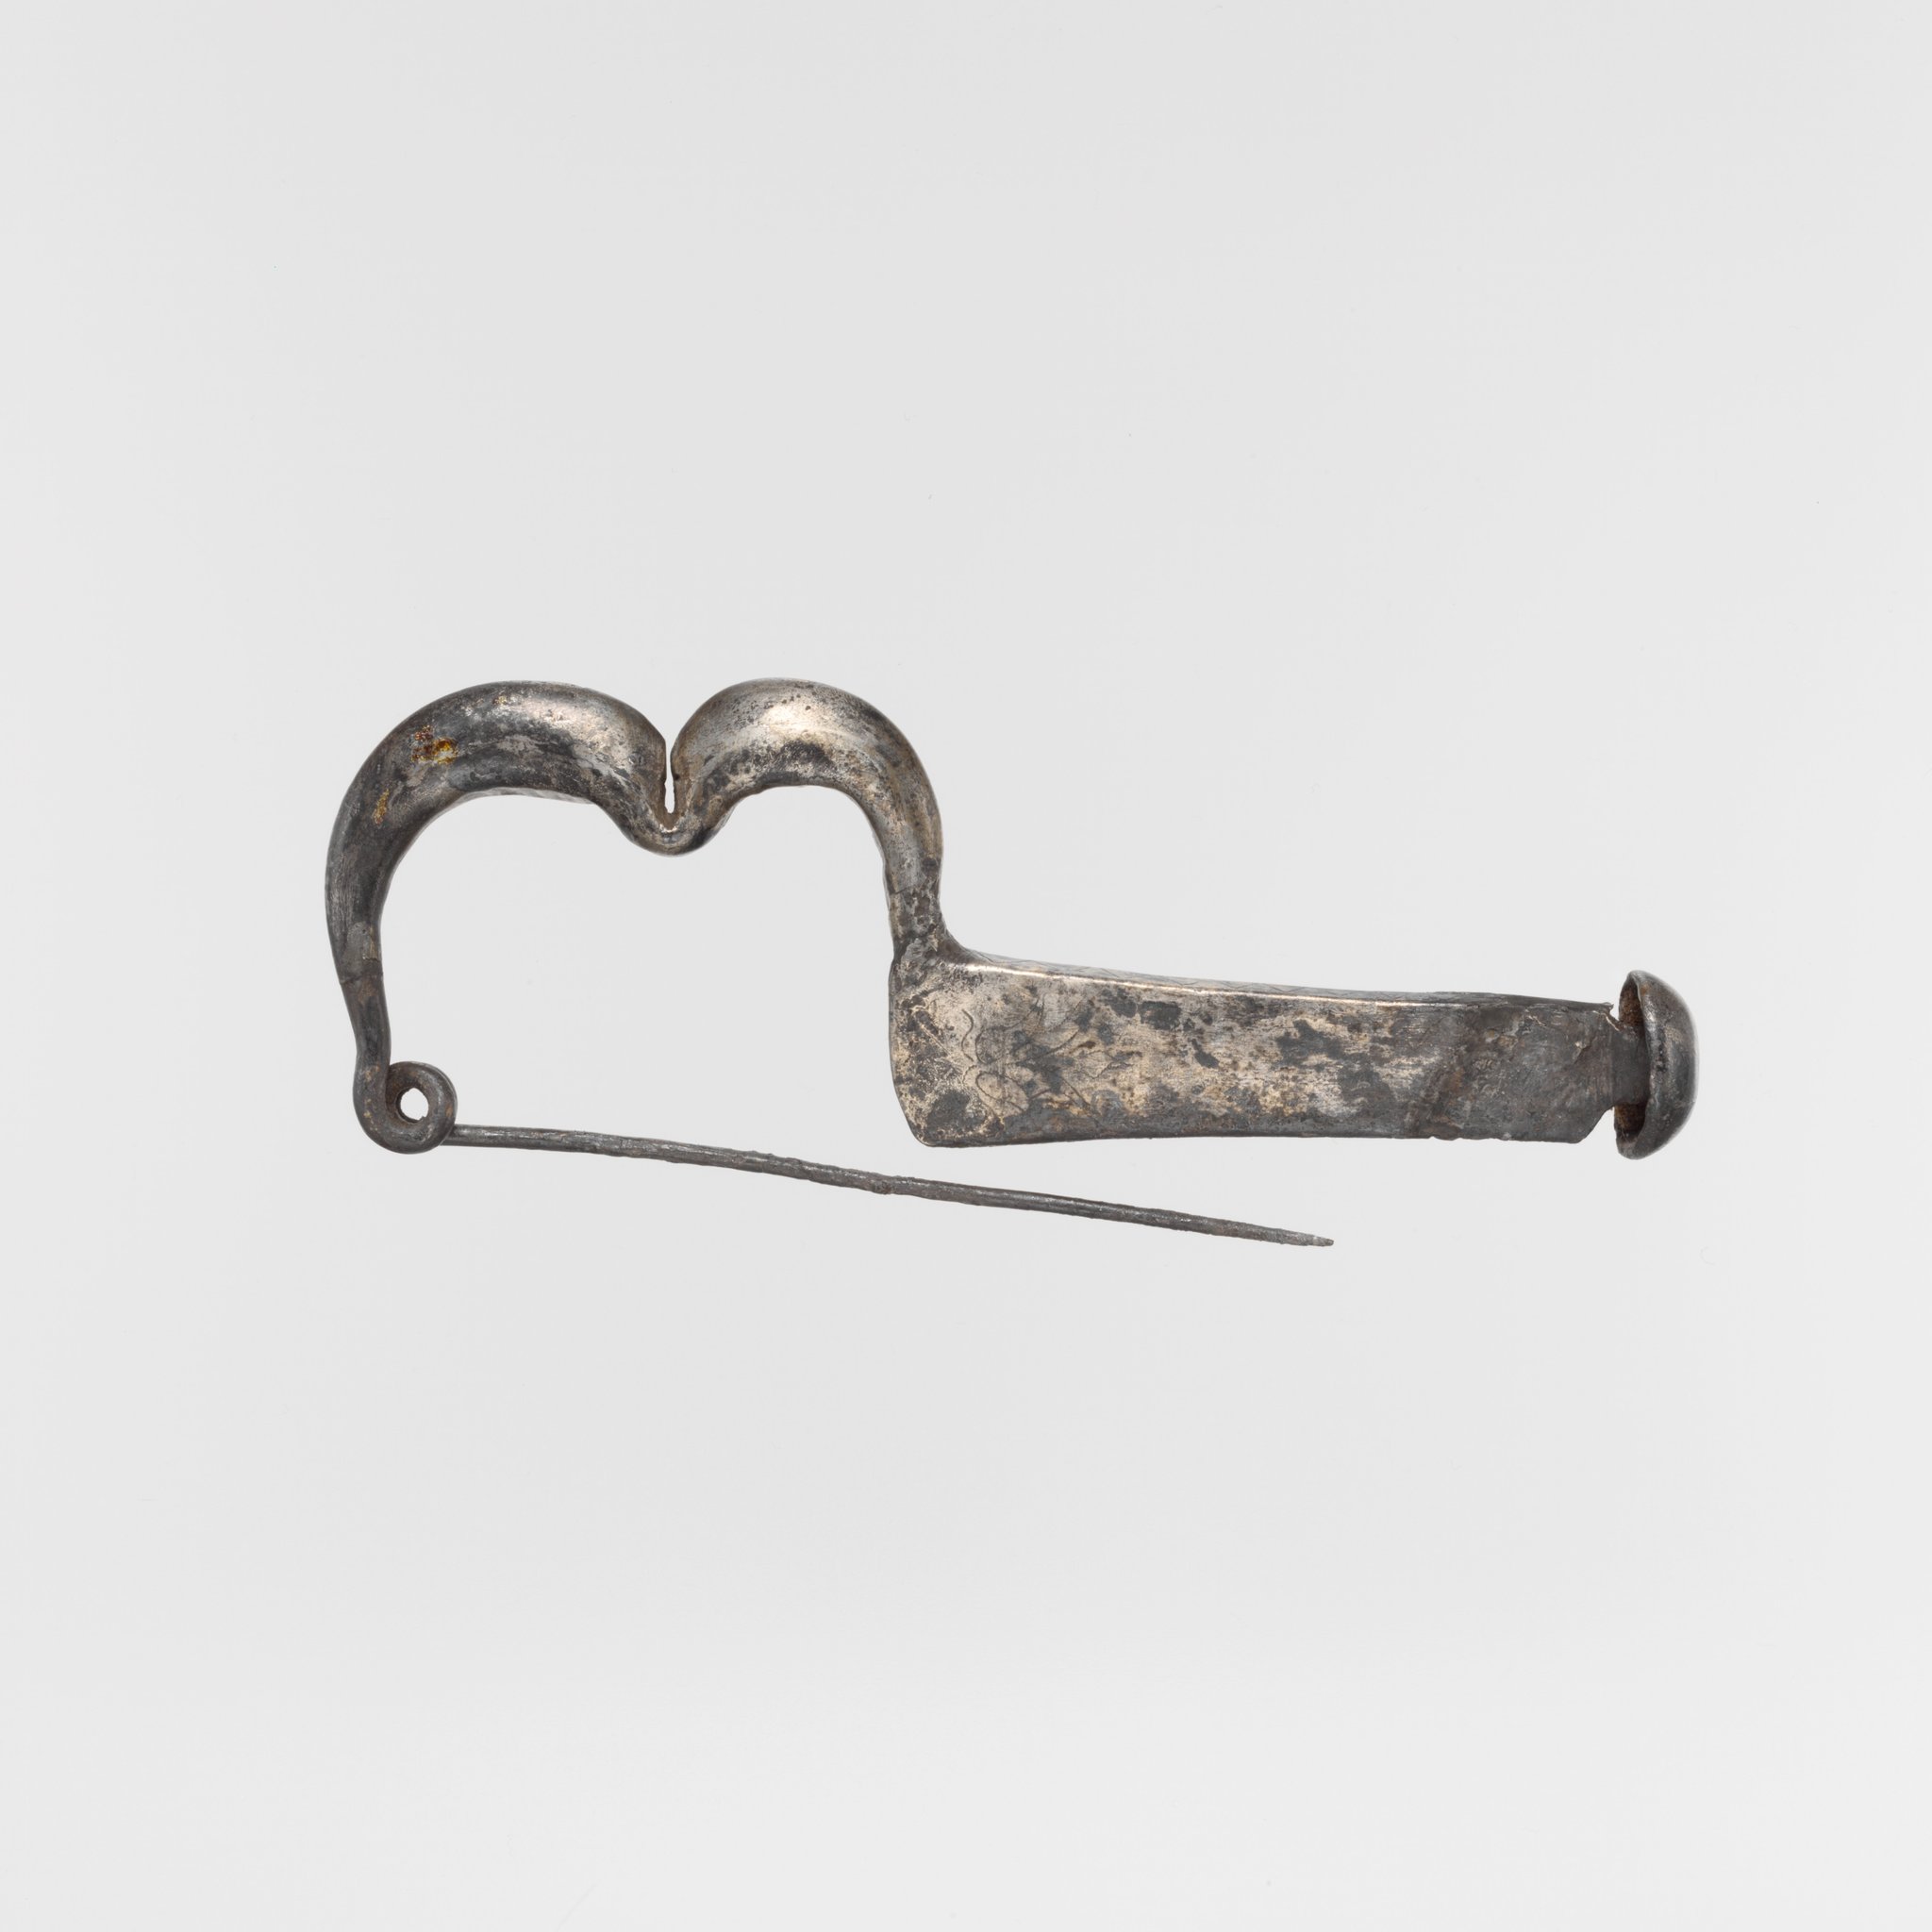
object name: fibula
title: Silver fibula (safety pin)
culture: greek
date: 400-301 BCE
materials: silver